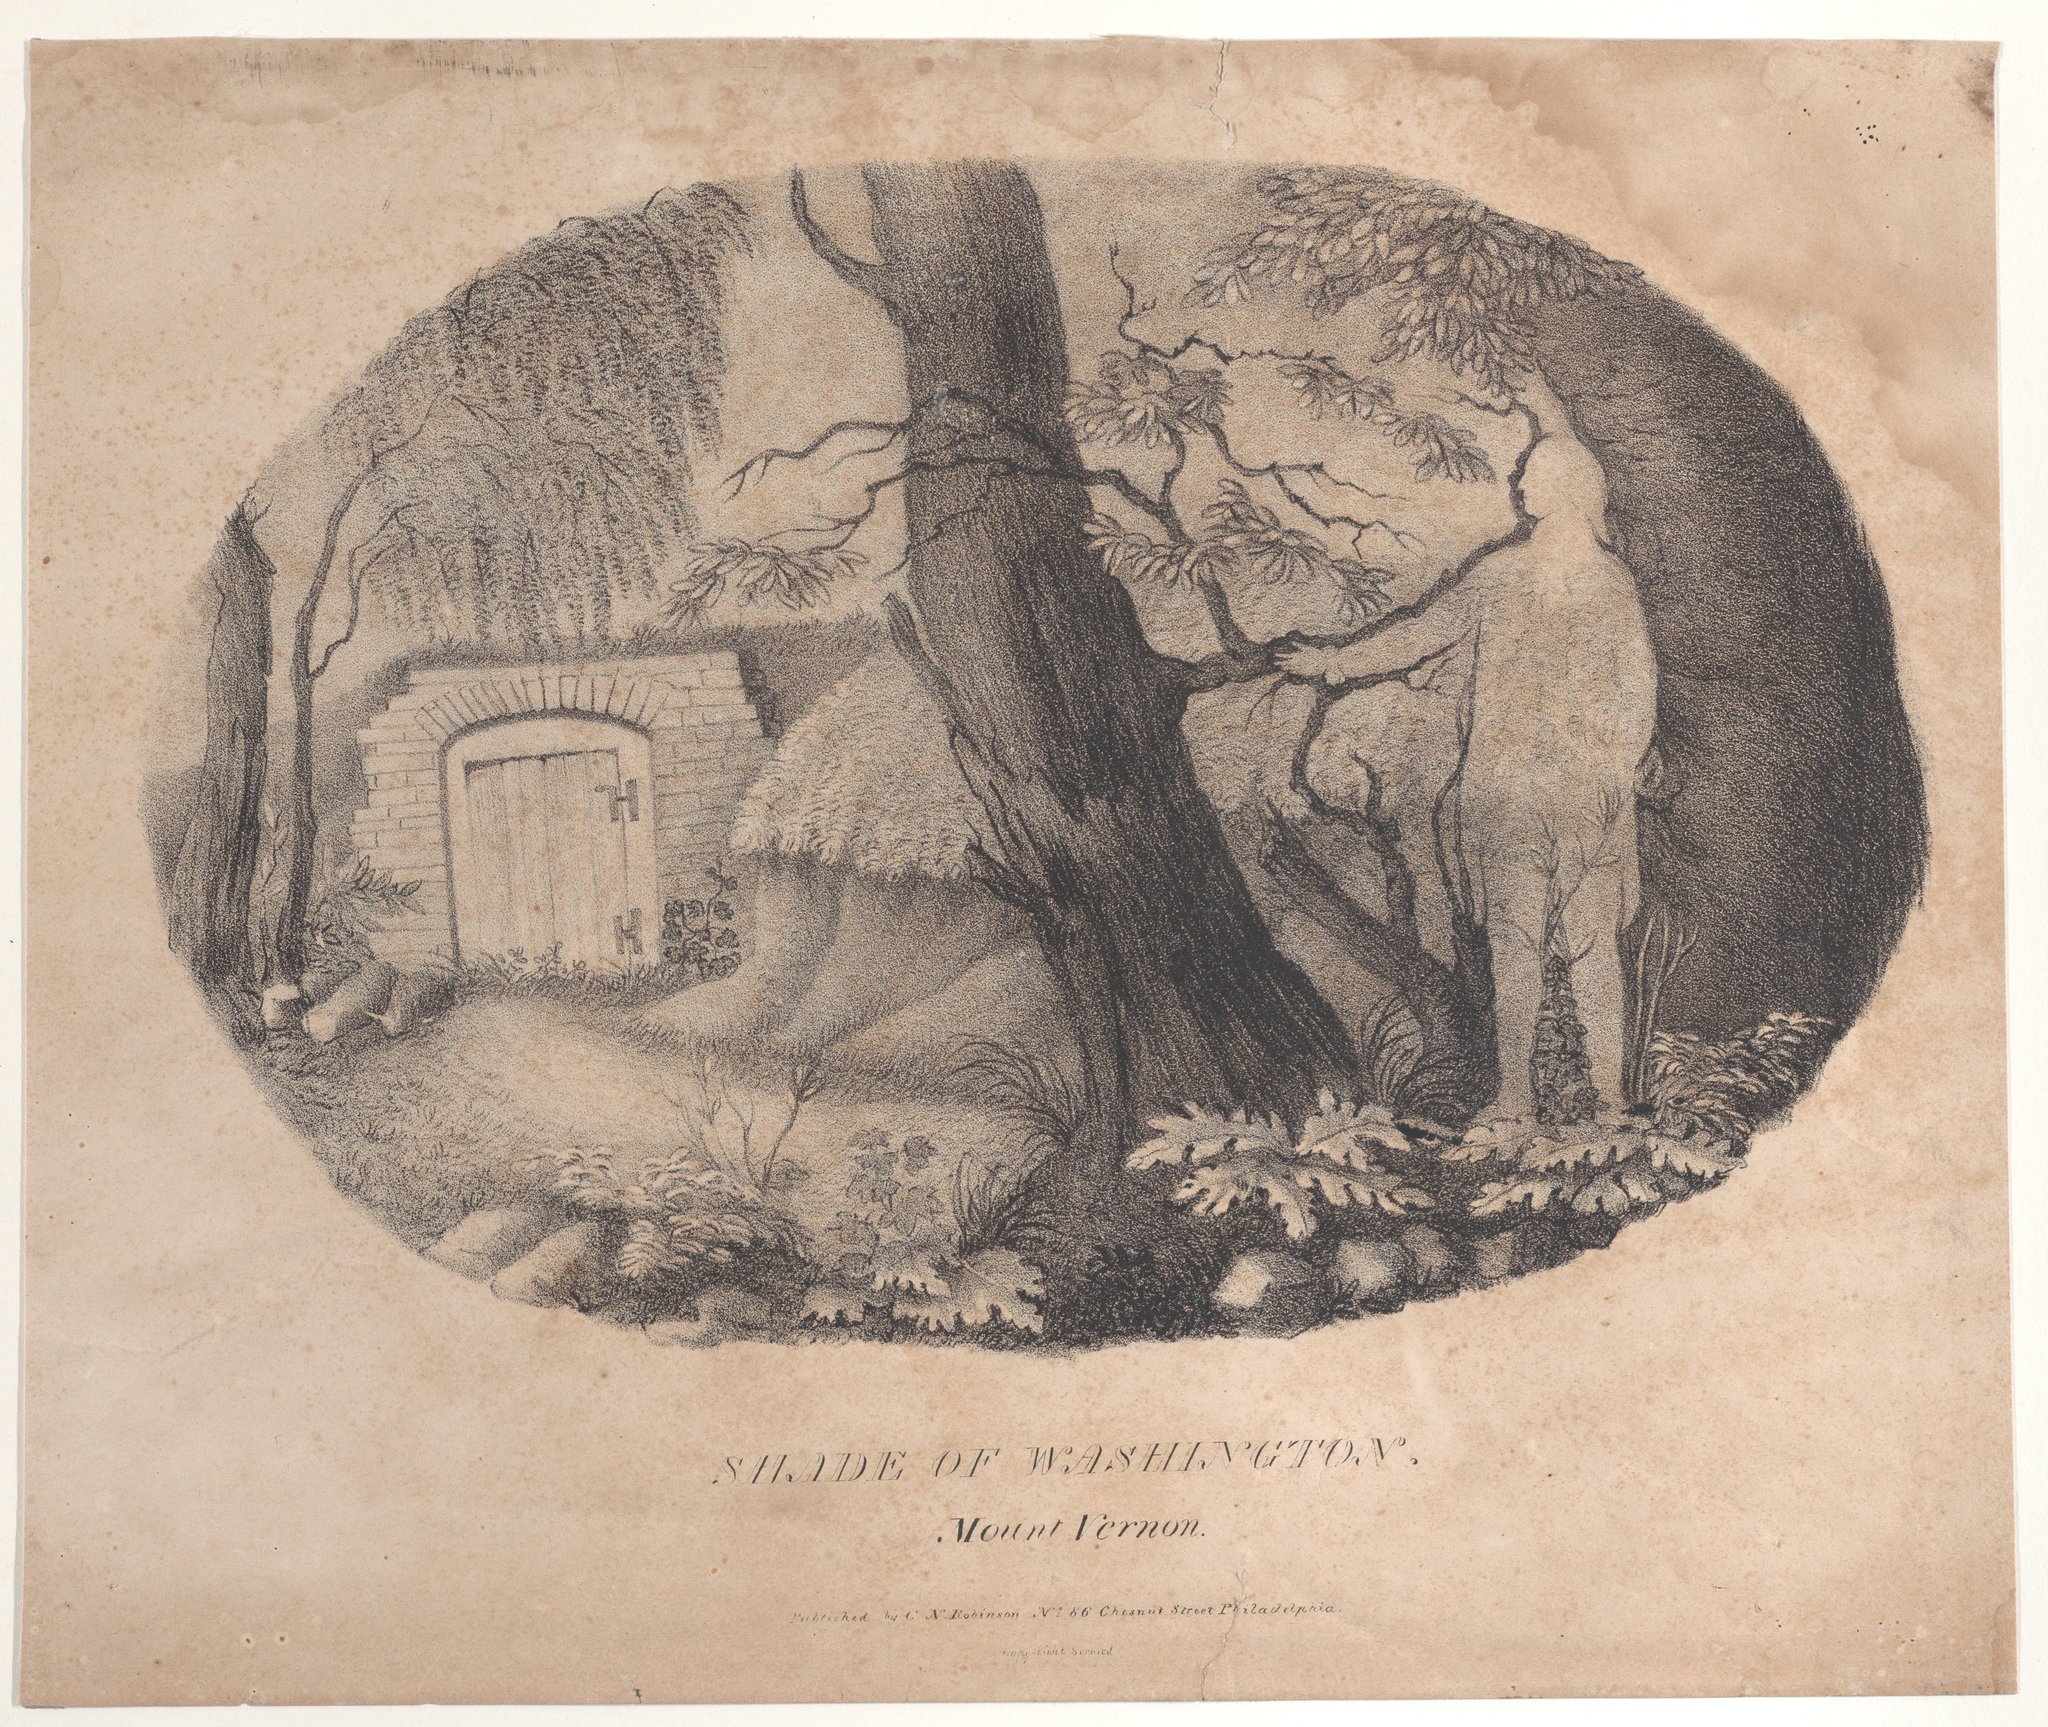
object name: print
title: Hidden silhouette of George Washington near his tomb at Mount Vernon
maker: anonymous, american, 19th century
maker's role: artist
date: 1801-1900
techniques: lithograph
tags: tombs,george washington